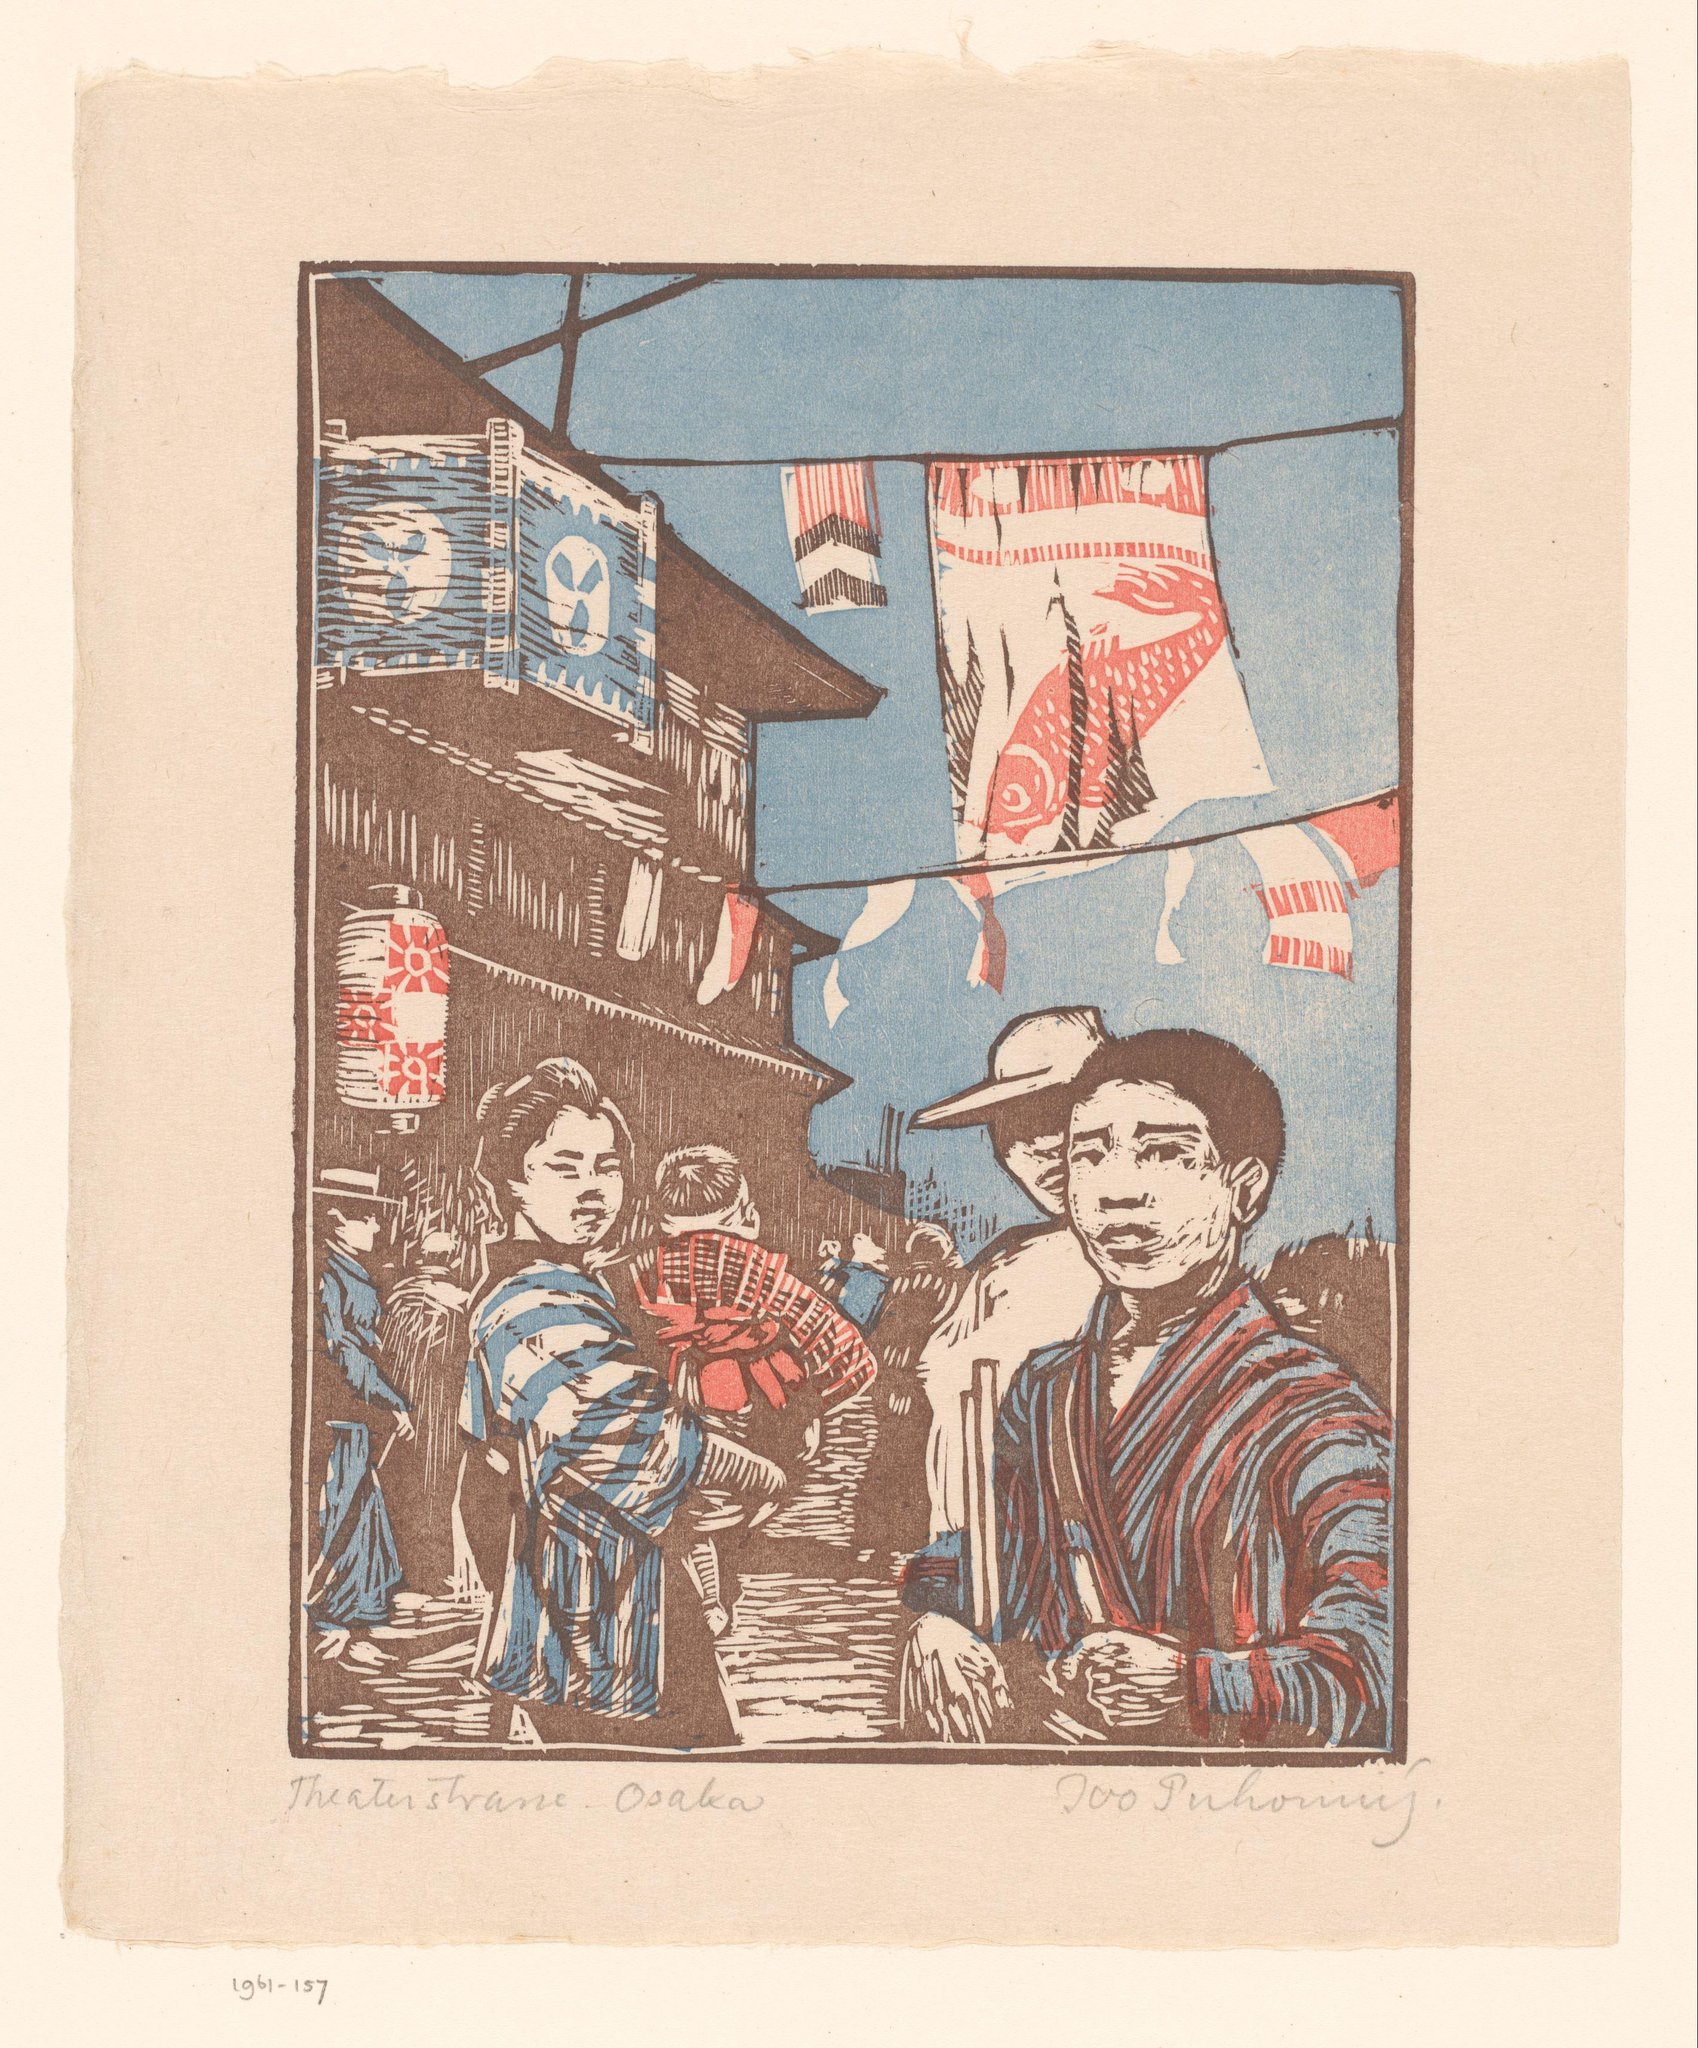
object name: print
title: Gezicht op Dōtonbori in Osaka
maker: ivo puhonny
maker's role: print maker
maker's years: 1876-1940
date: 1886-1940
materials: paper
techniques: woodcut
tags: city-view, and landscape with man-made constructions, japanese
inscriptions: collector's mark: Lugt 2228